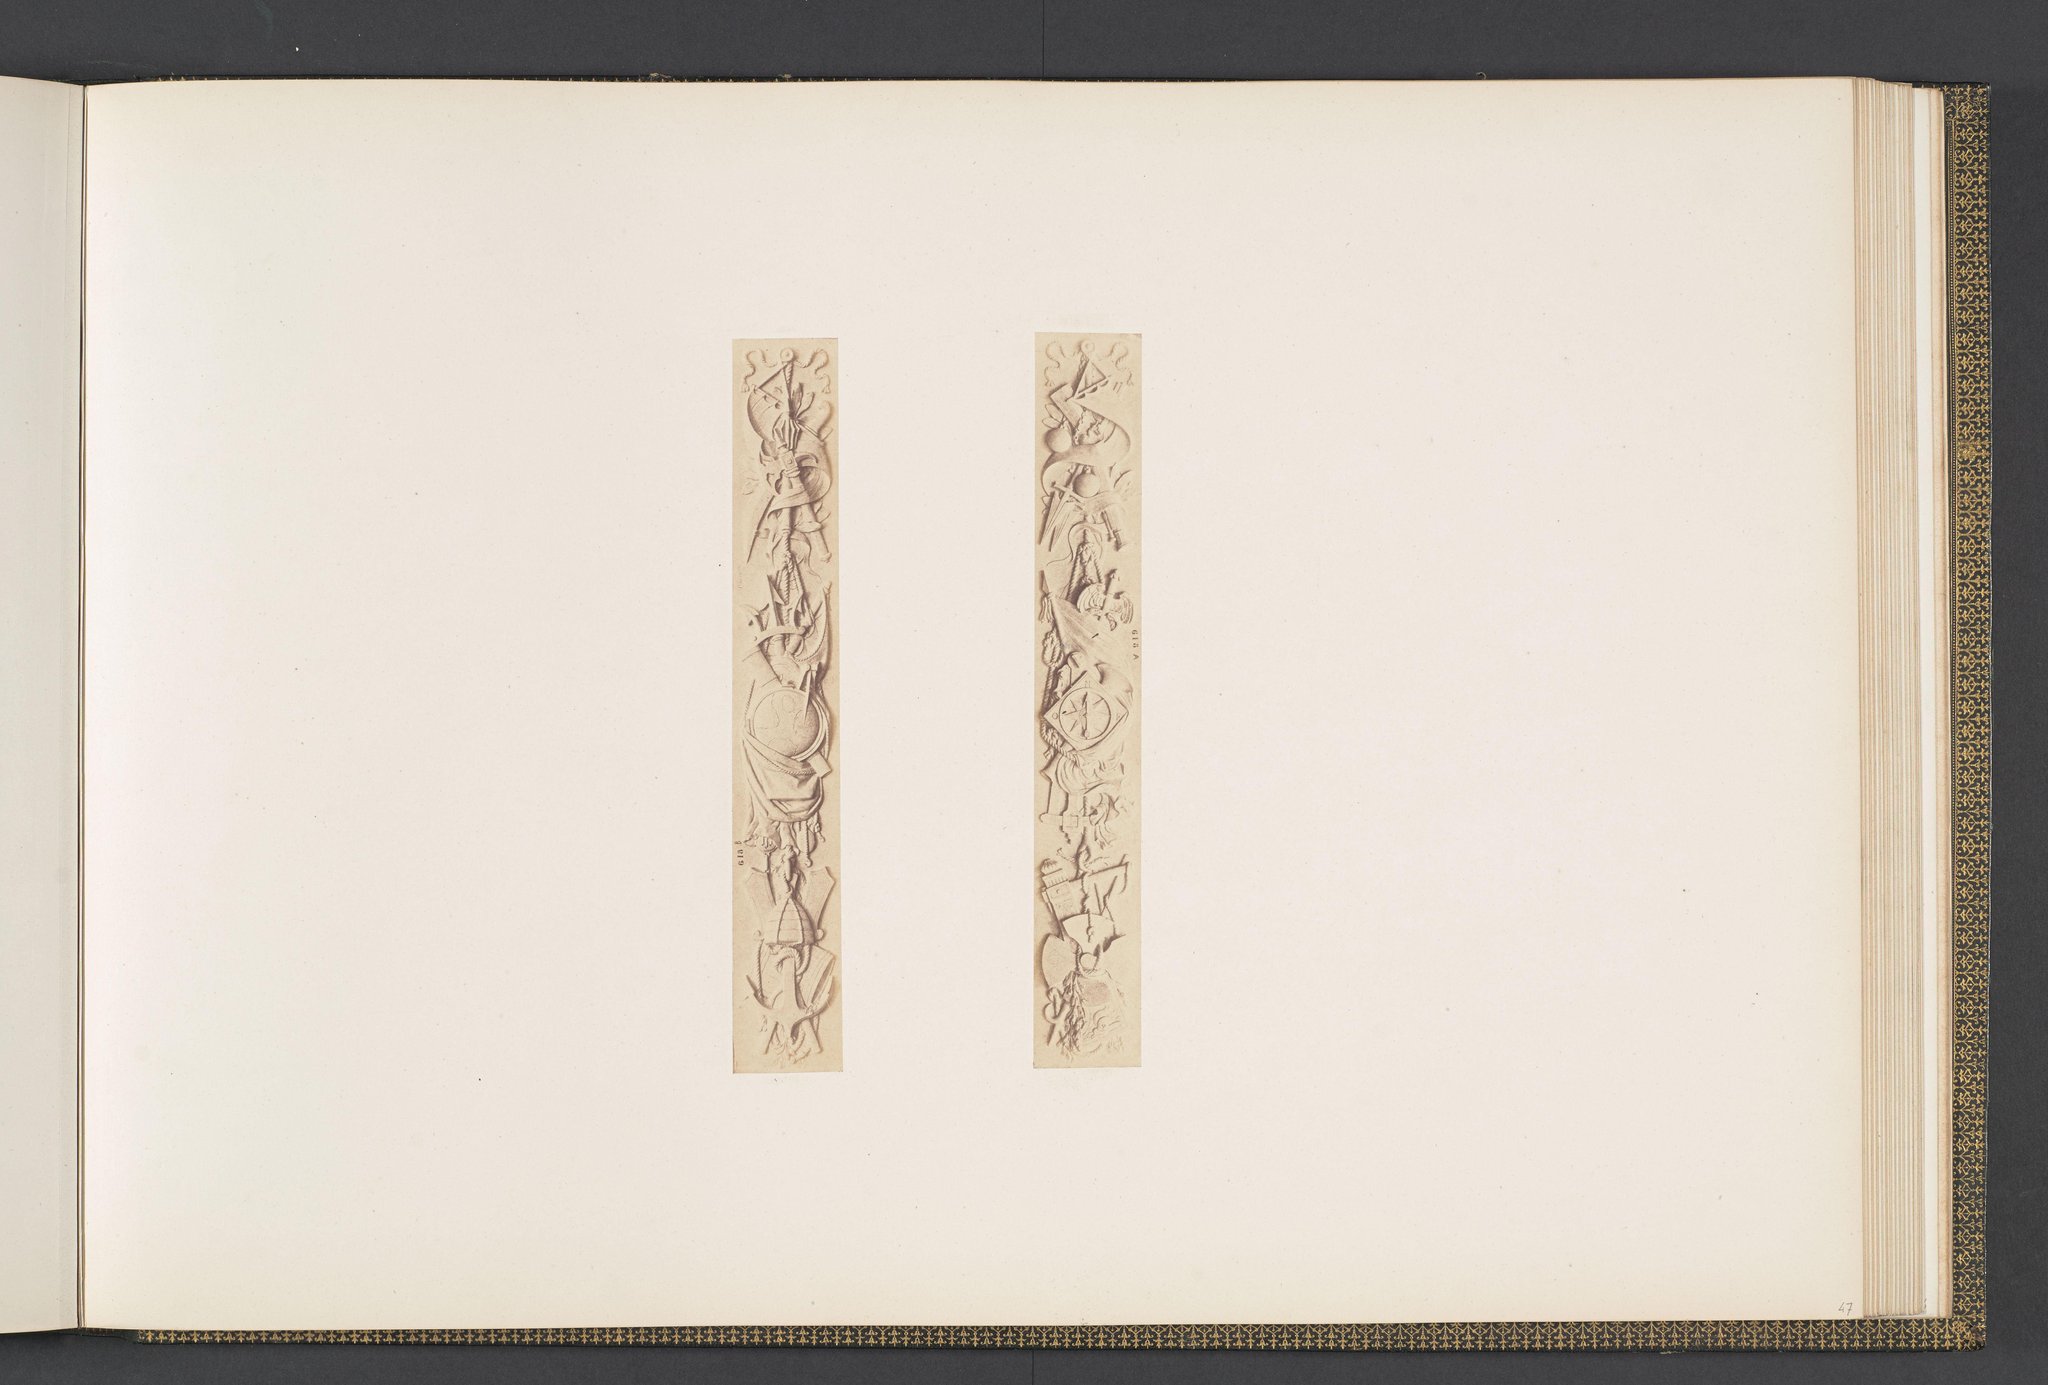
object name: photograph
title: Gipsmodellen voor gevelversieringen aan de Cour Lefuel van het Palais du Louvre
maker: édouard denis baldus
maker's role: fotograaf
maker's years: 1813-1889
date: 1855-1857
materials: paper, photographic support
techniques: salted paper print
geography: paris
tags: permanent exhibition, museum, ornamenting, decorating ~ applied arts, paris, tuileries palace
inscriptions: number: ‘618 B en 618 A’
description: Onderdeel van Réunion des Tuileries au Louvre 1852-1857, album 3.